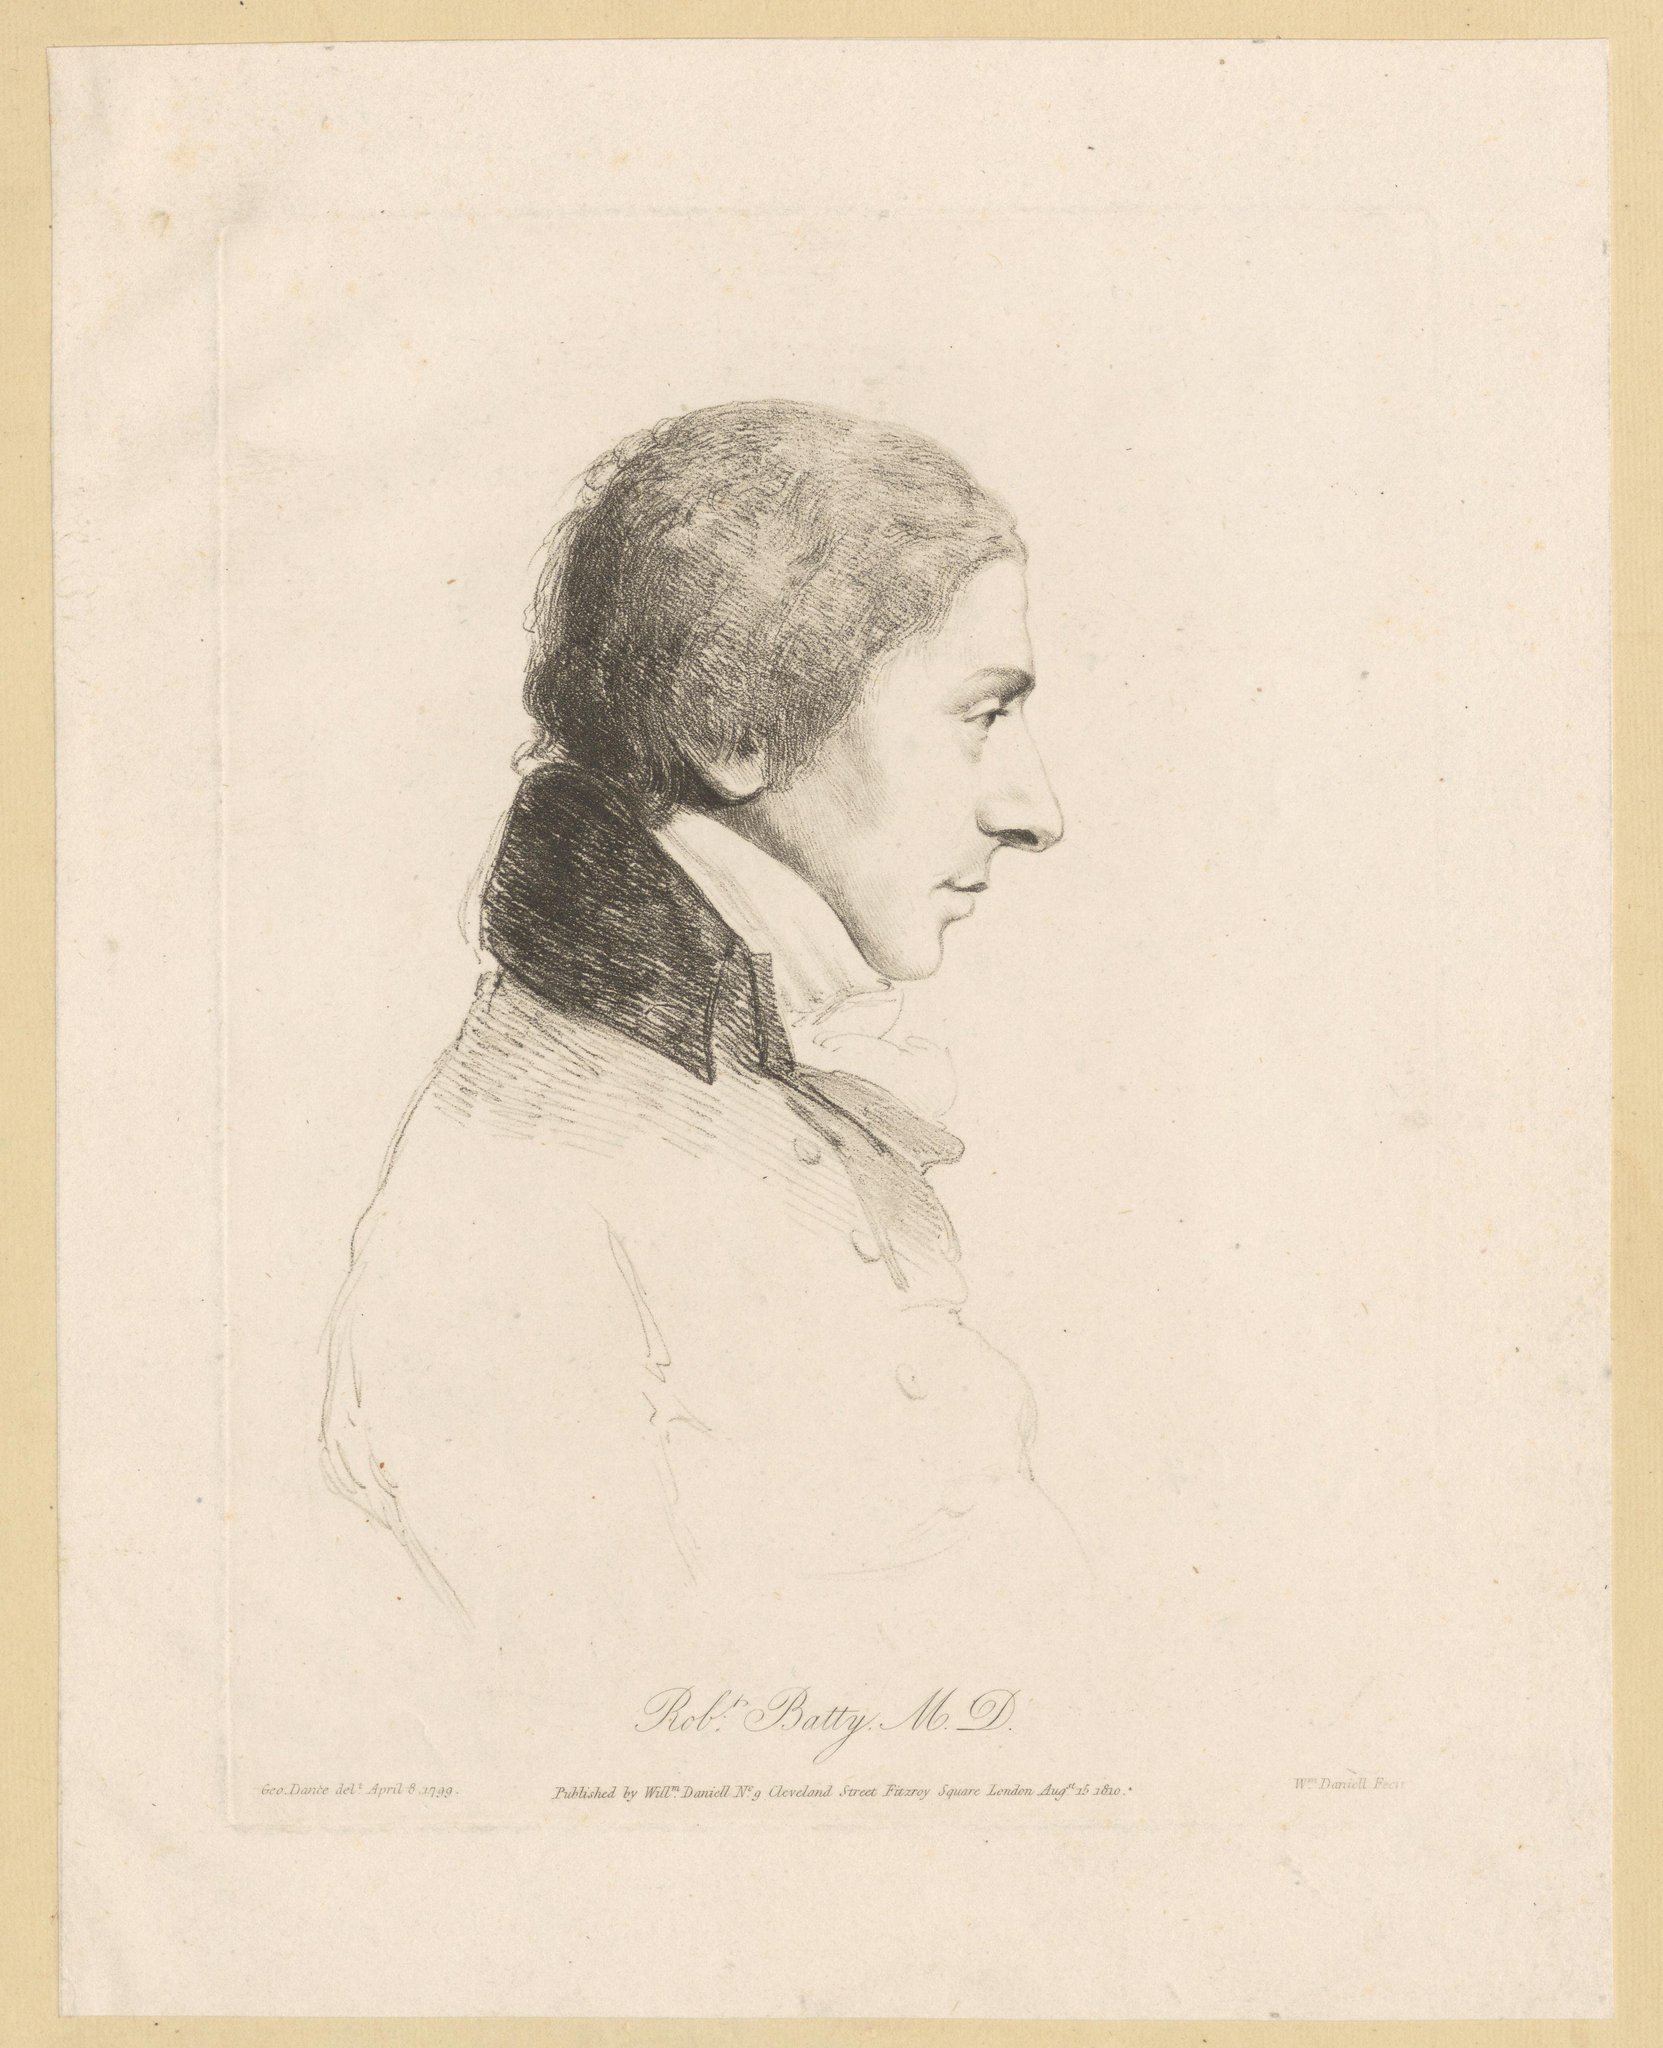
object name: print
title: Portret van Robert Batty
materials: paper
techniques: printmaking, etching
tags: historical persons, physician, doctor (+ portrait of scholar, scientist)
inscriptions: collector's mark: Lugt 2228